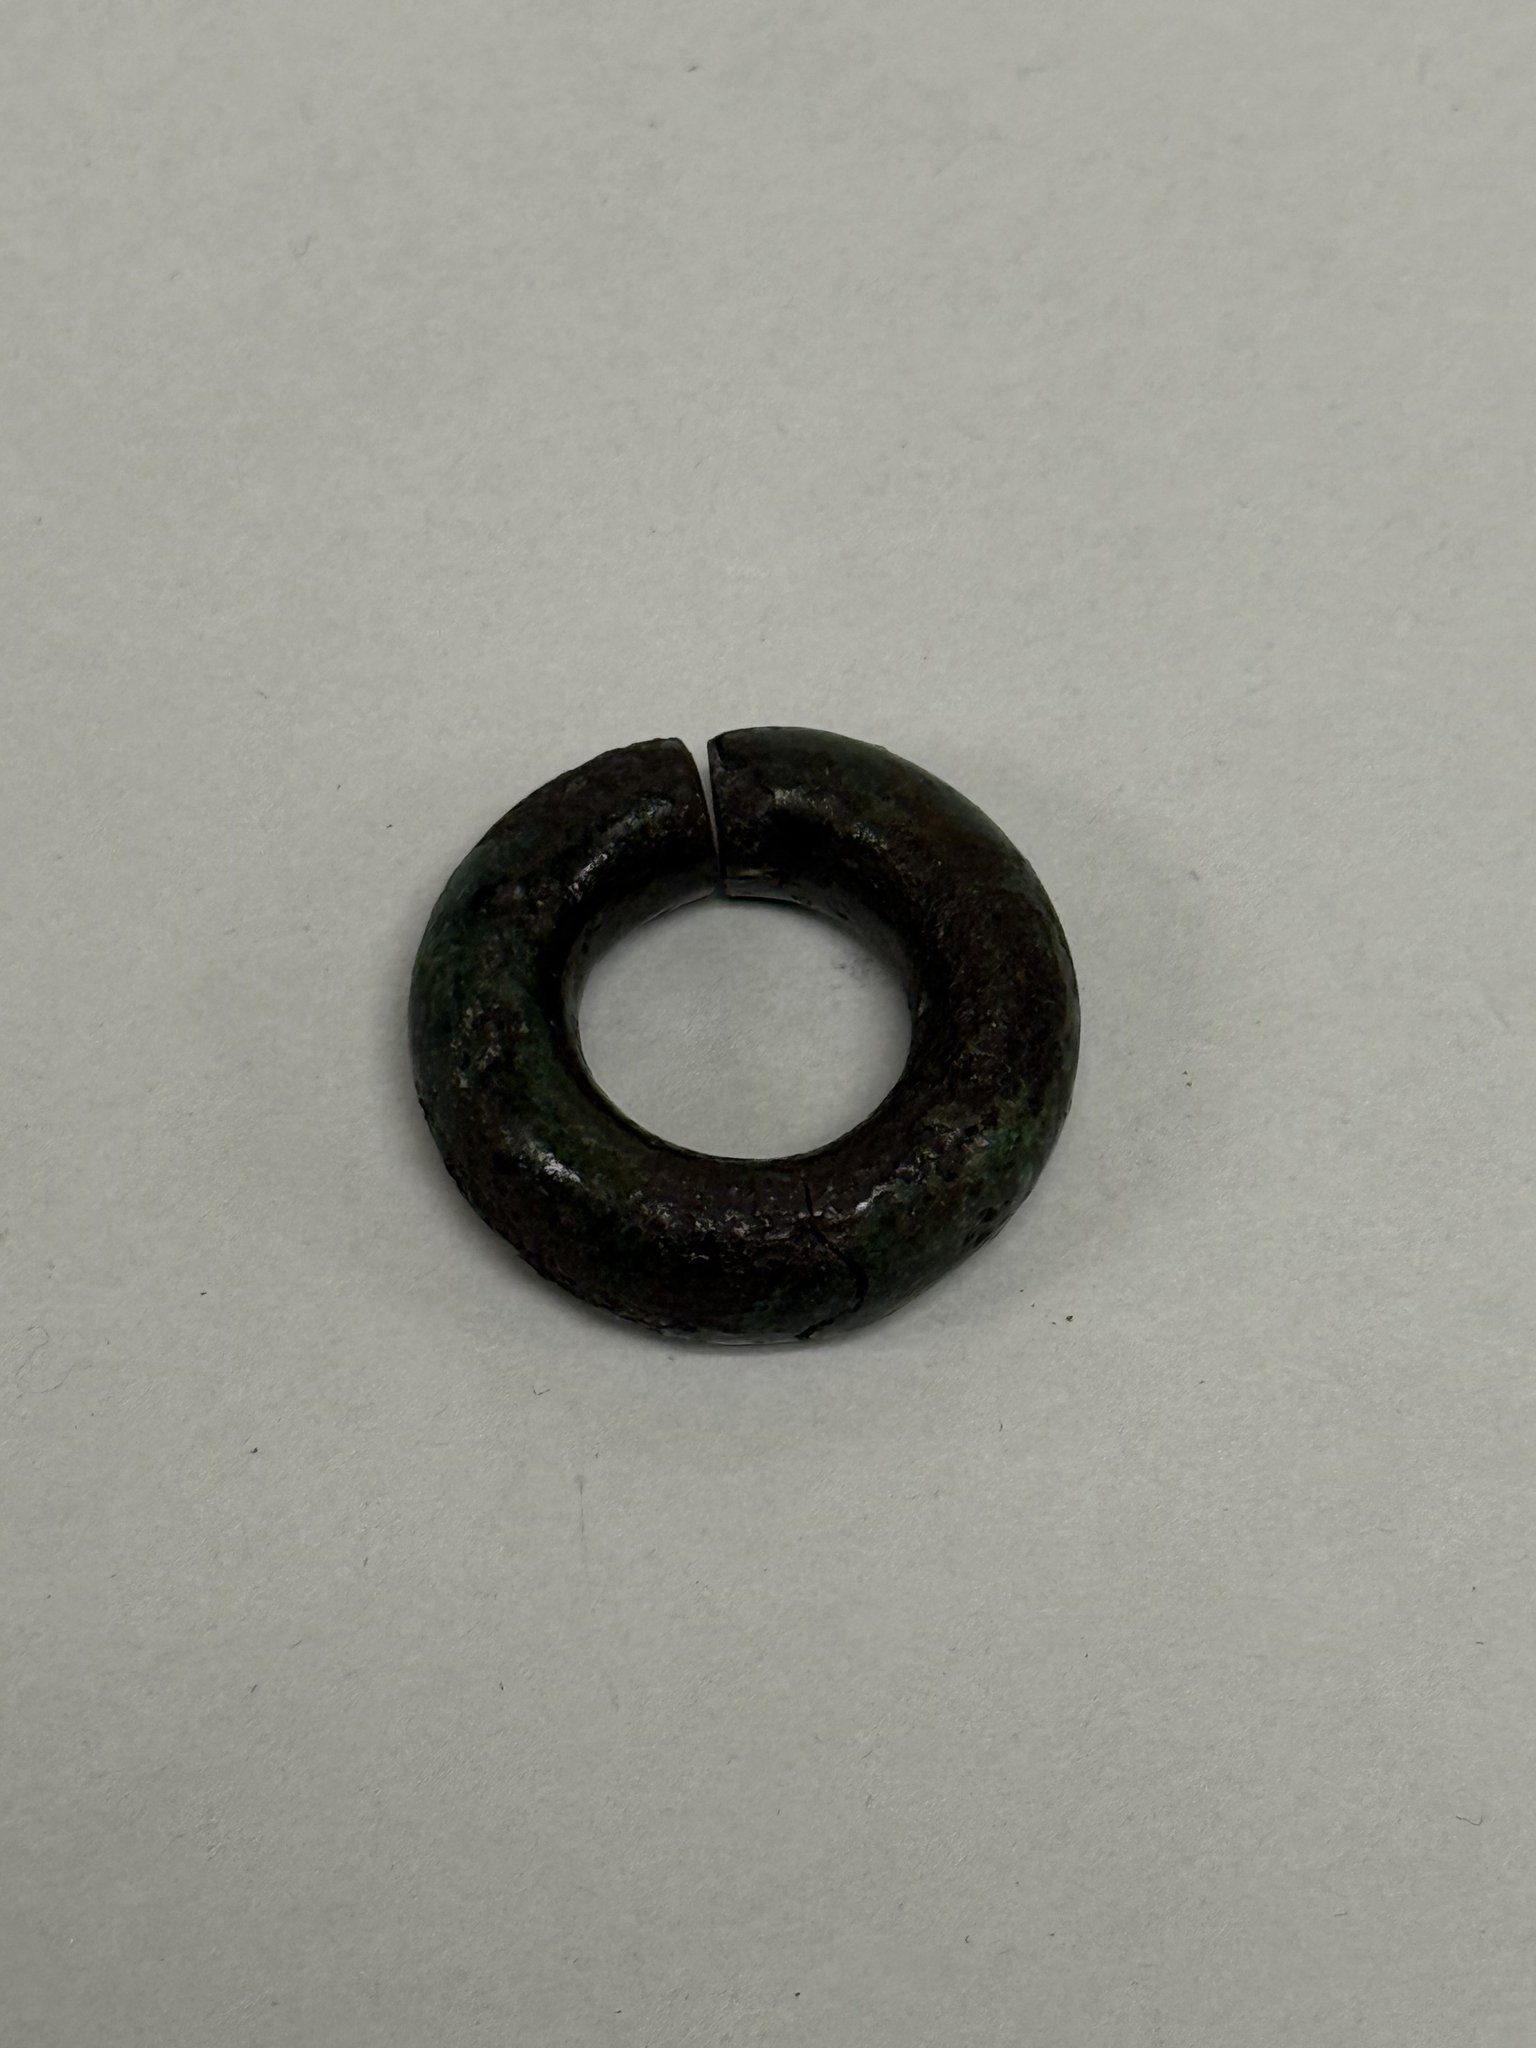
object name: earring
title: Earrings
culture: japanese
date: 601-700